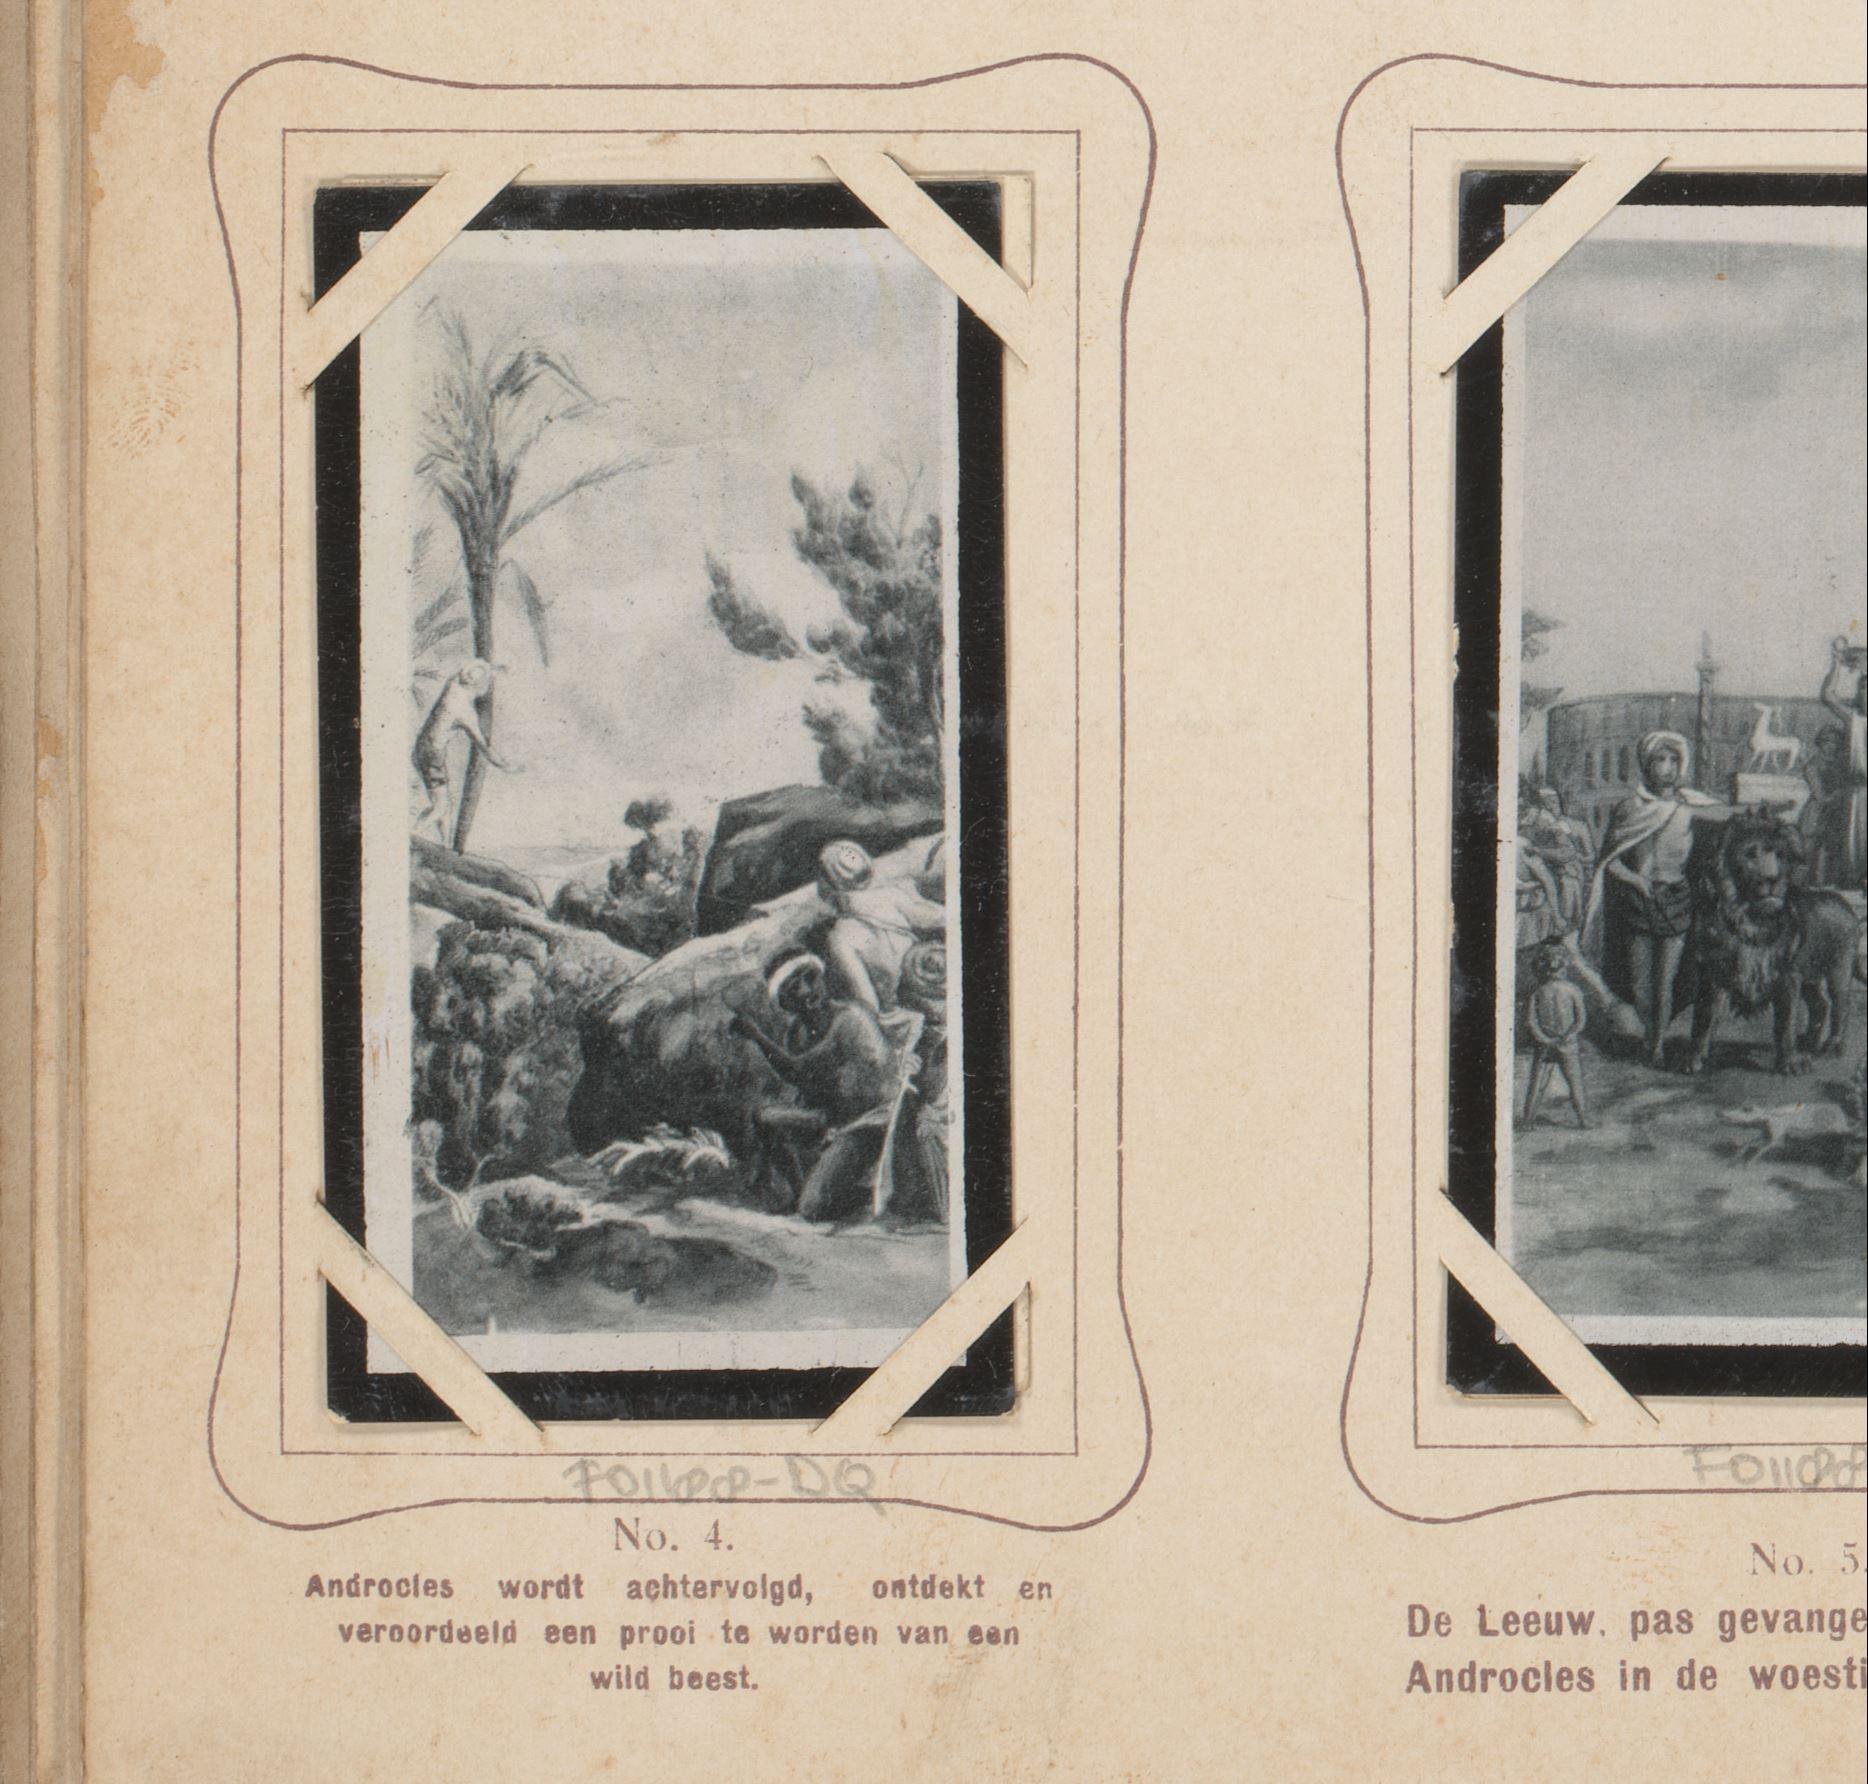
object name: album leaf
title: Reproductie van een tekening van Androclus die wordt gevangen en veroordeeld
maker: Anonymous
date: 1906-1907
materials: paper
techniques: photograph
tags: (story of) androclus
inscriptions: inscription: ‘No. 4./ Androcles wordt achtervolgd, ontdekt en veroordeeld een prooi te worden van een wild beest.’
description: Deze prent maakt deel uit van een album.